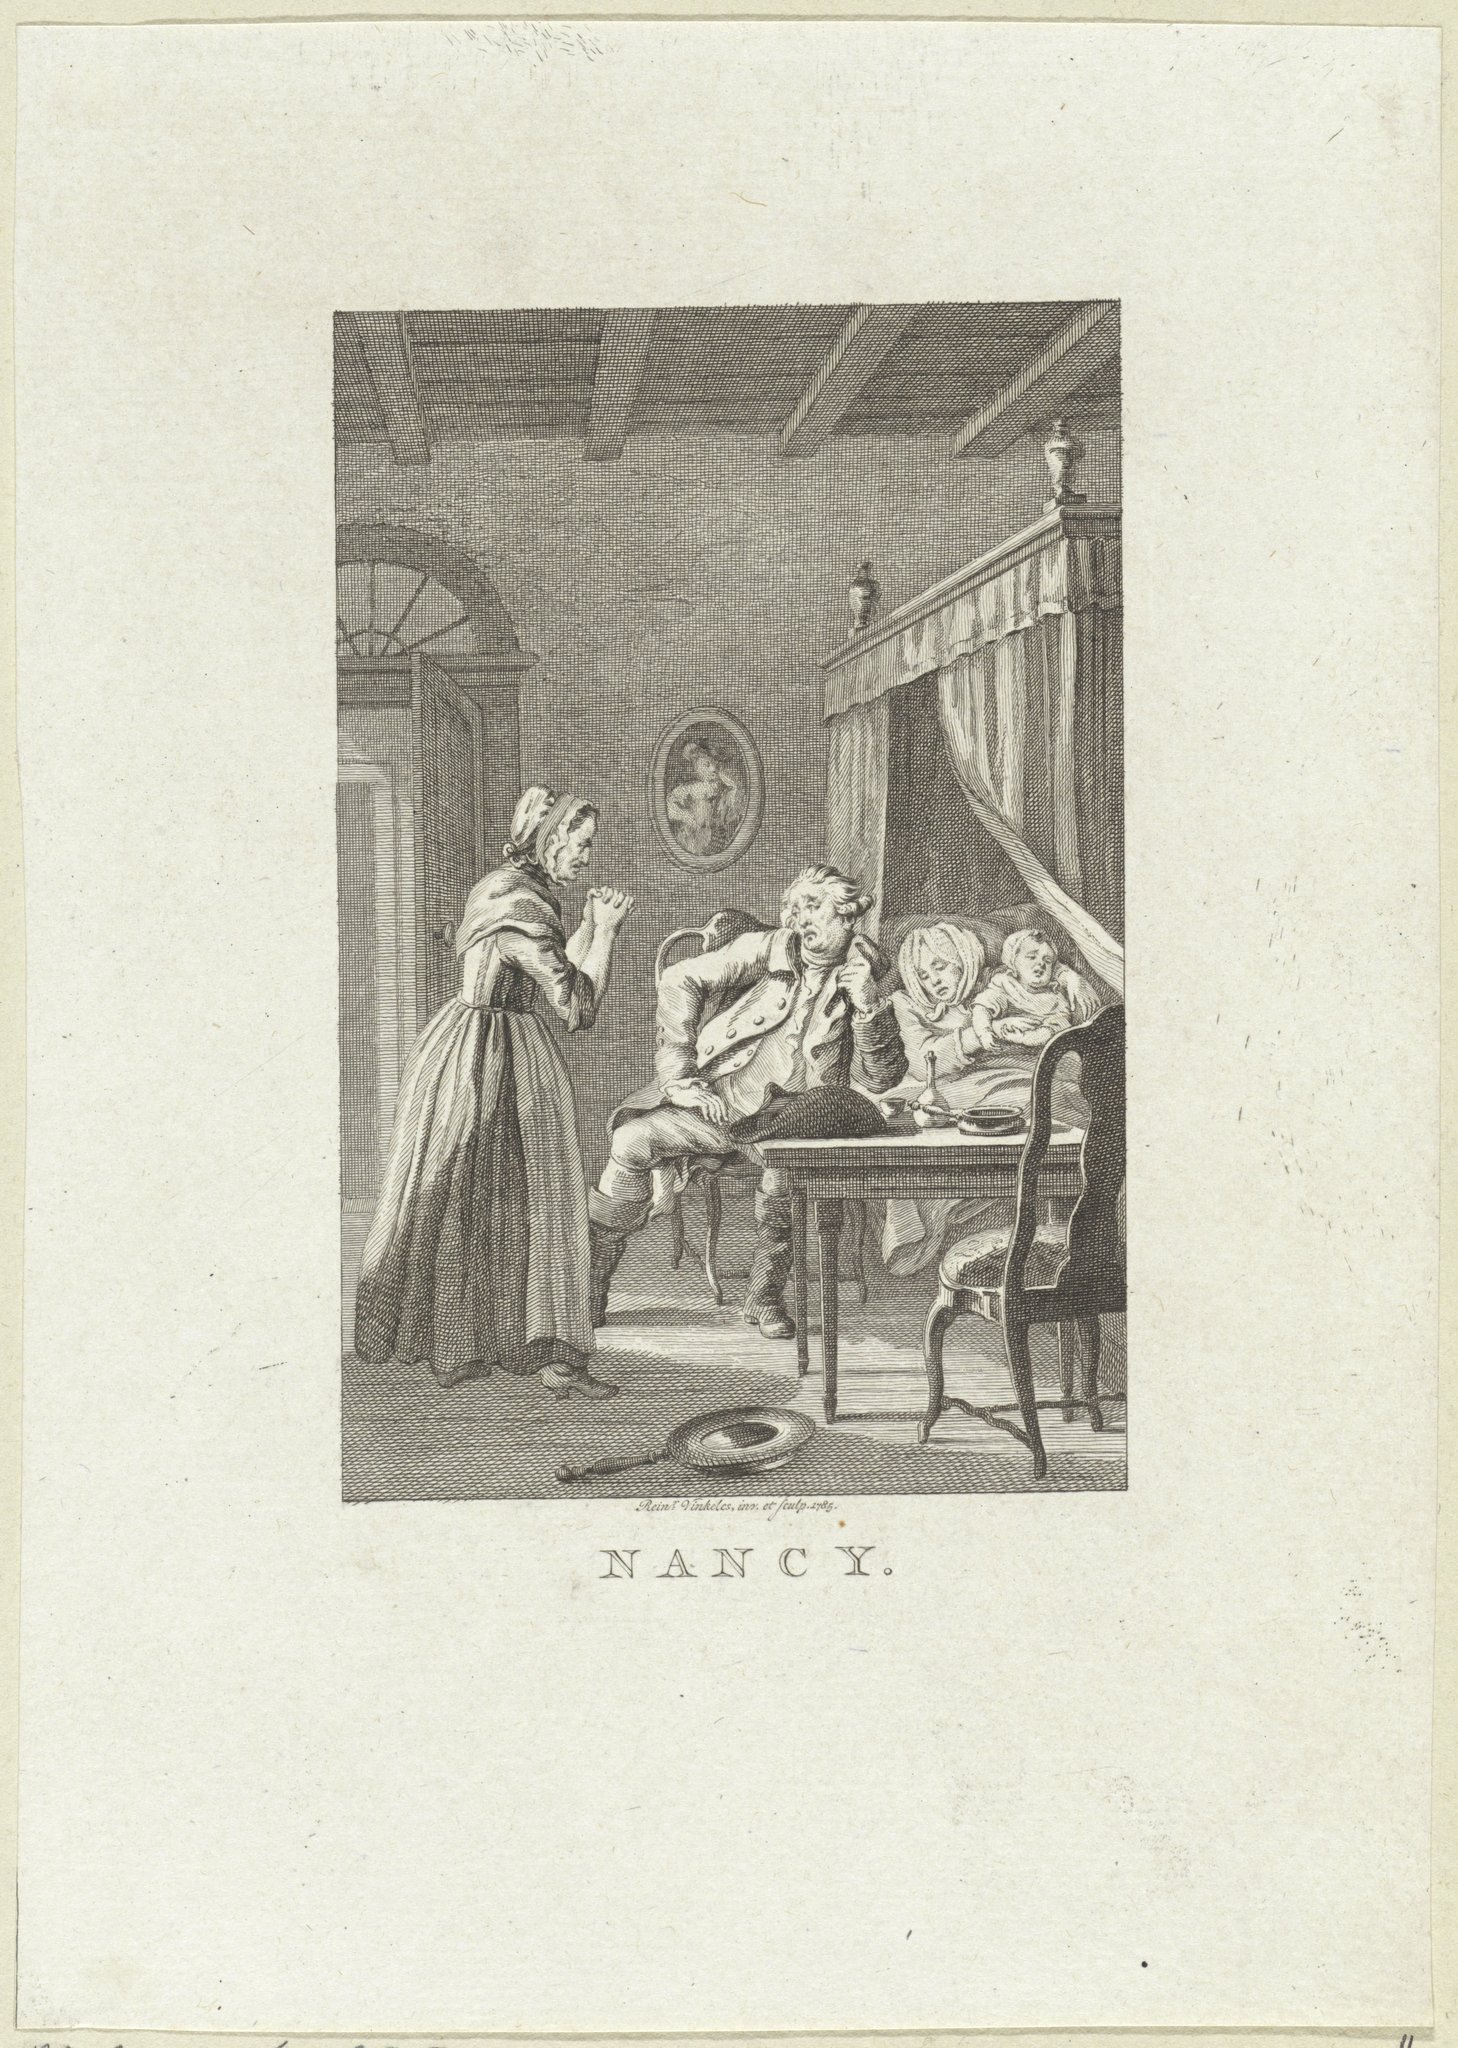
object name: print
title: Man en vrouw bij een zieke moeder met kind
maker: reinier vinkeles (i)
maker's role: draughtsman, print maker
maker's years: 1741-1816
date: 1785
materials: paper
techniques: engraving, etching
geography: amsterdam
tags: weeping, picture, painting, one person praying, visiting the sick; sick person together with others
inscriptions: collector's mark: Lugt 240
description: Deze prent is ook gebruikt als illustratie bij het verhaal 'Nancy' voor: Baculard d'Arnaud, F.T.M. de. Zedelijke verhaalen, deel 9. Amsterdam: A. Mens Jansz., 1785.